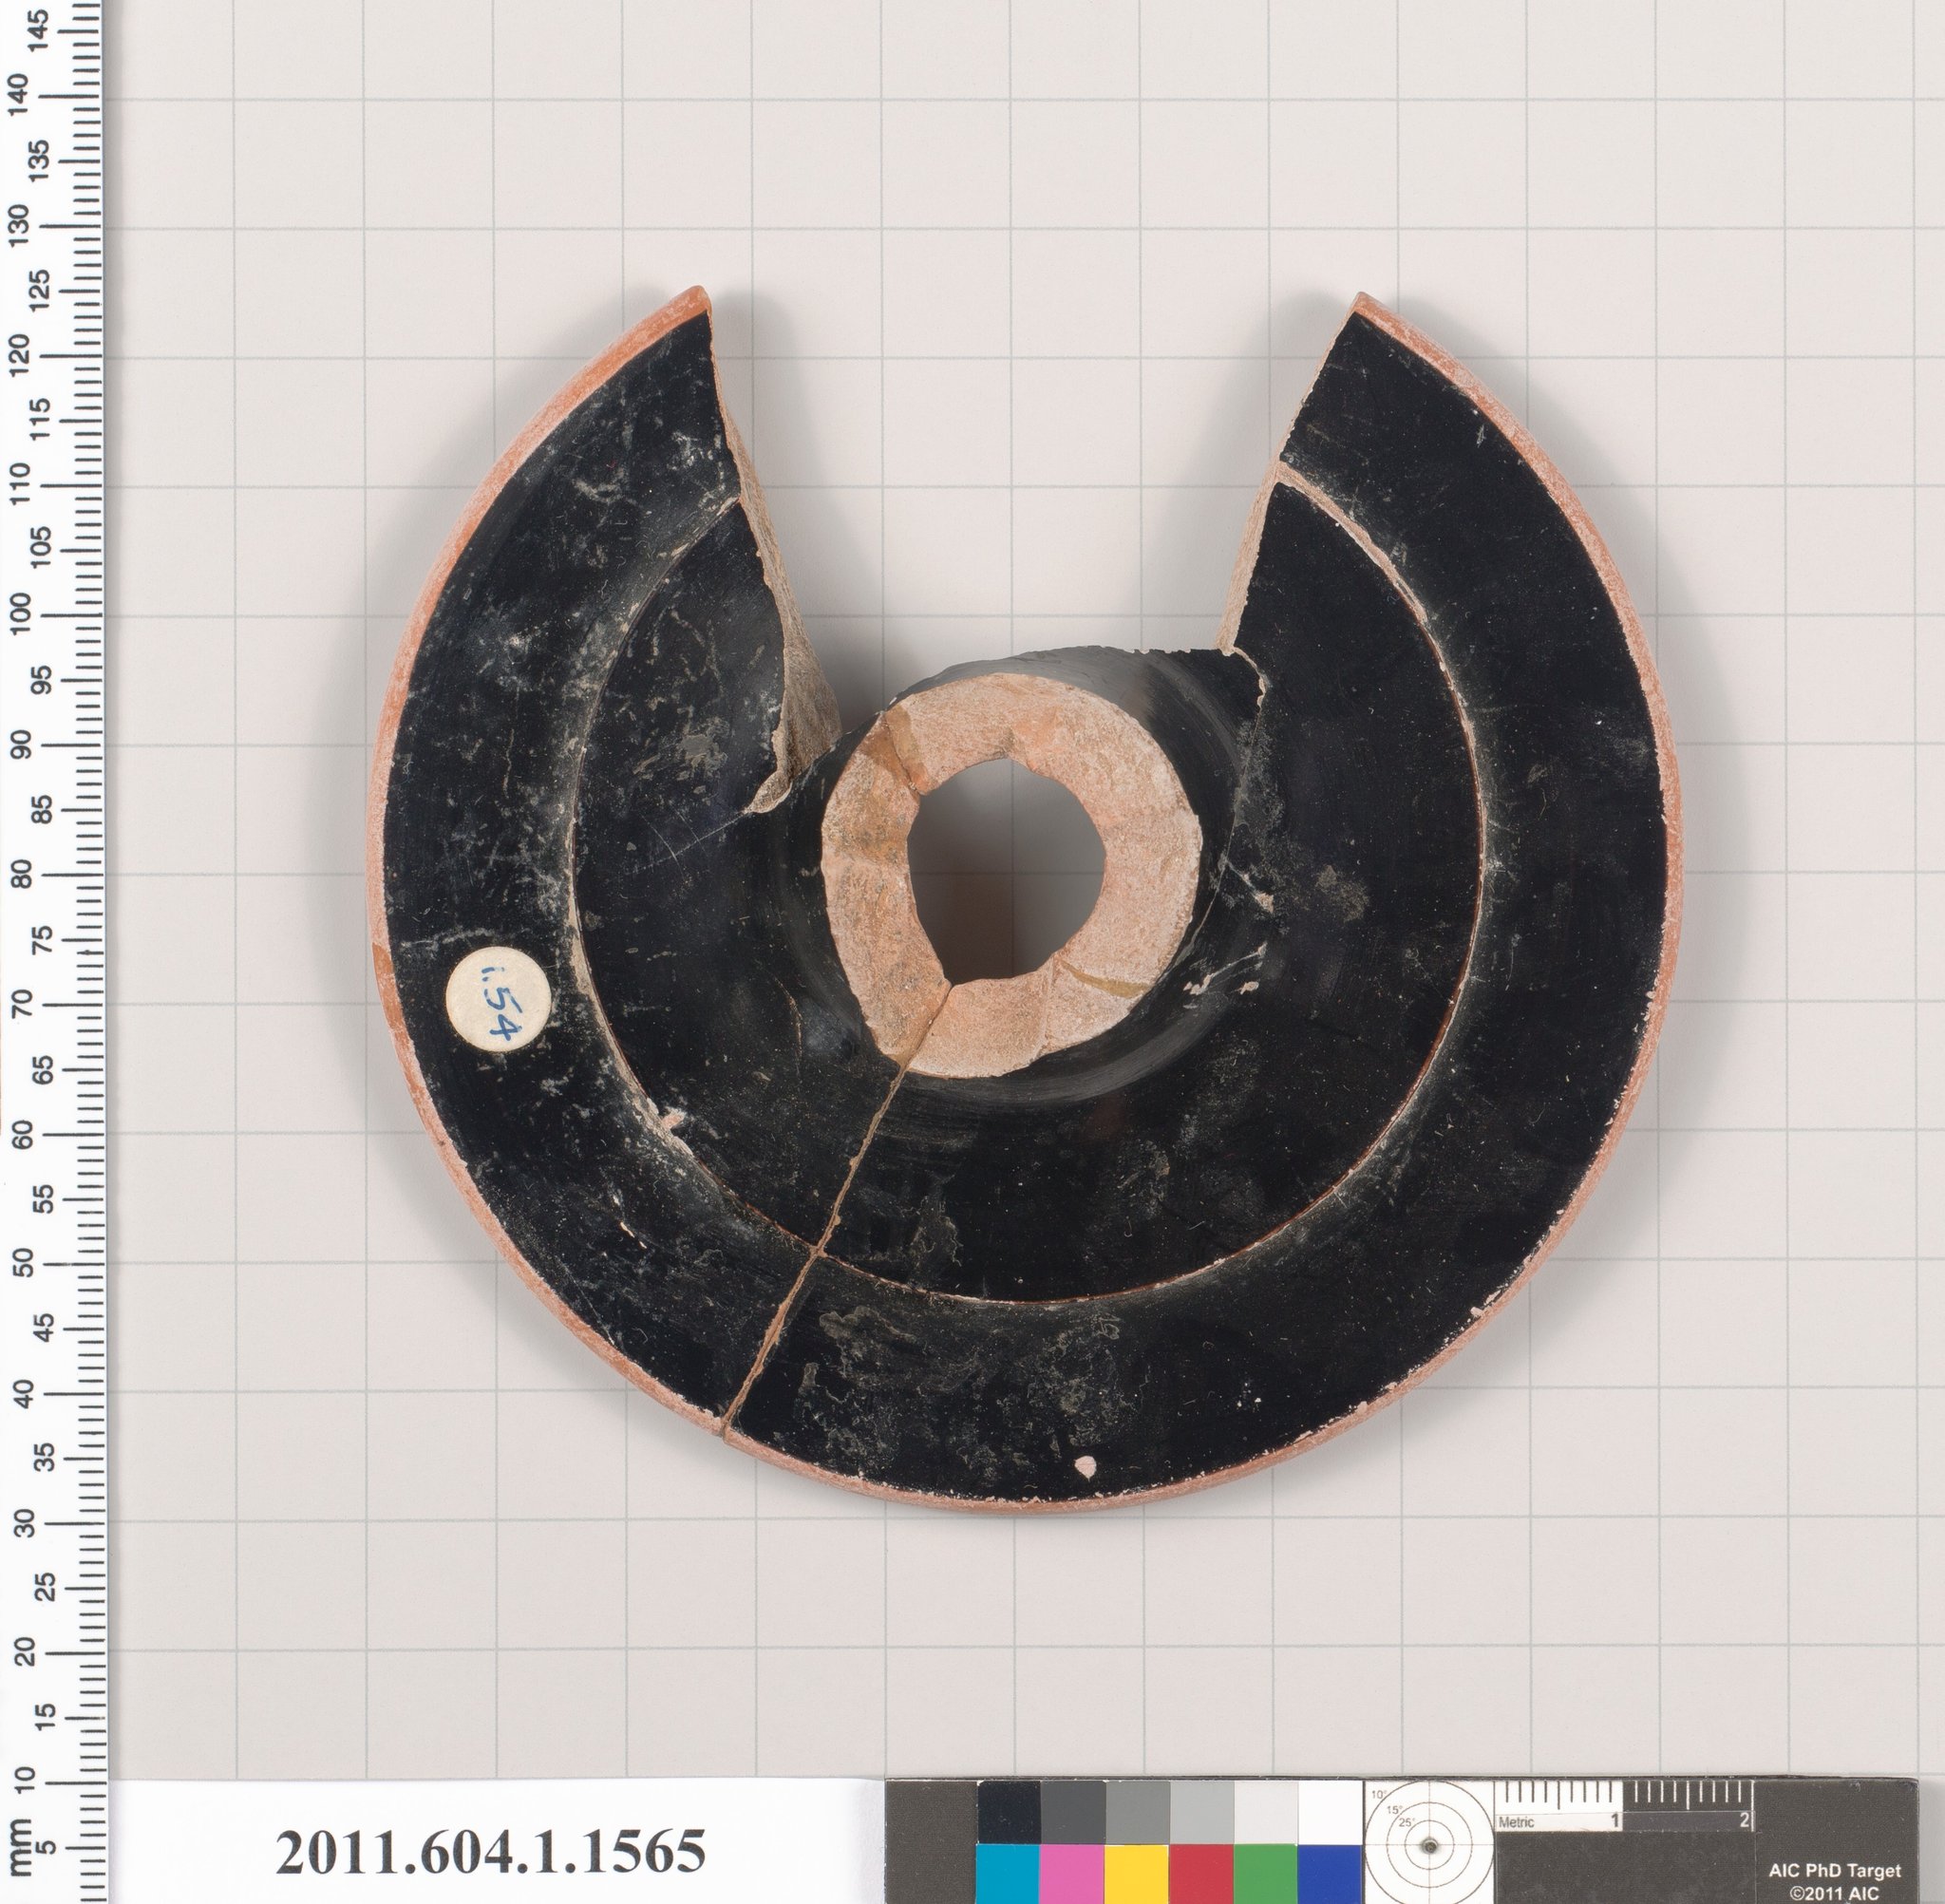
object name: kylix fragment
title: Terracotta fragment of a kylix (drinking cup)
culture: greek, attic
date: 500-401 BCE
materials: terracotta